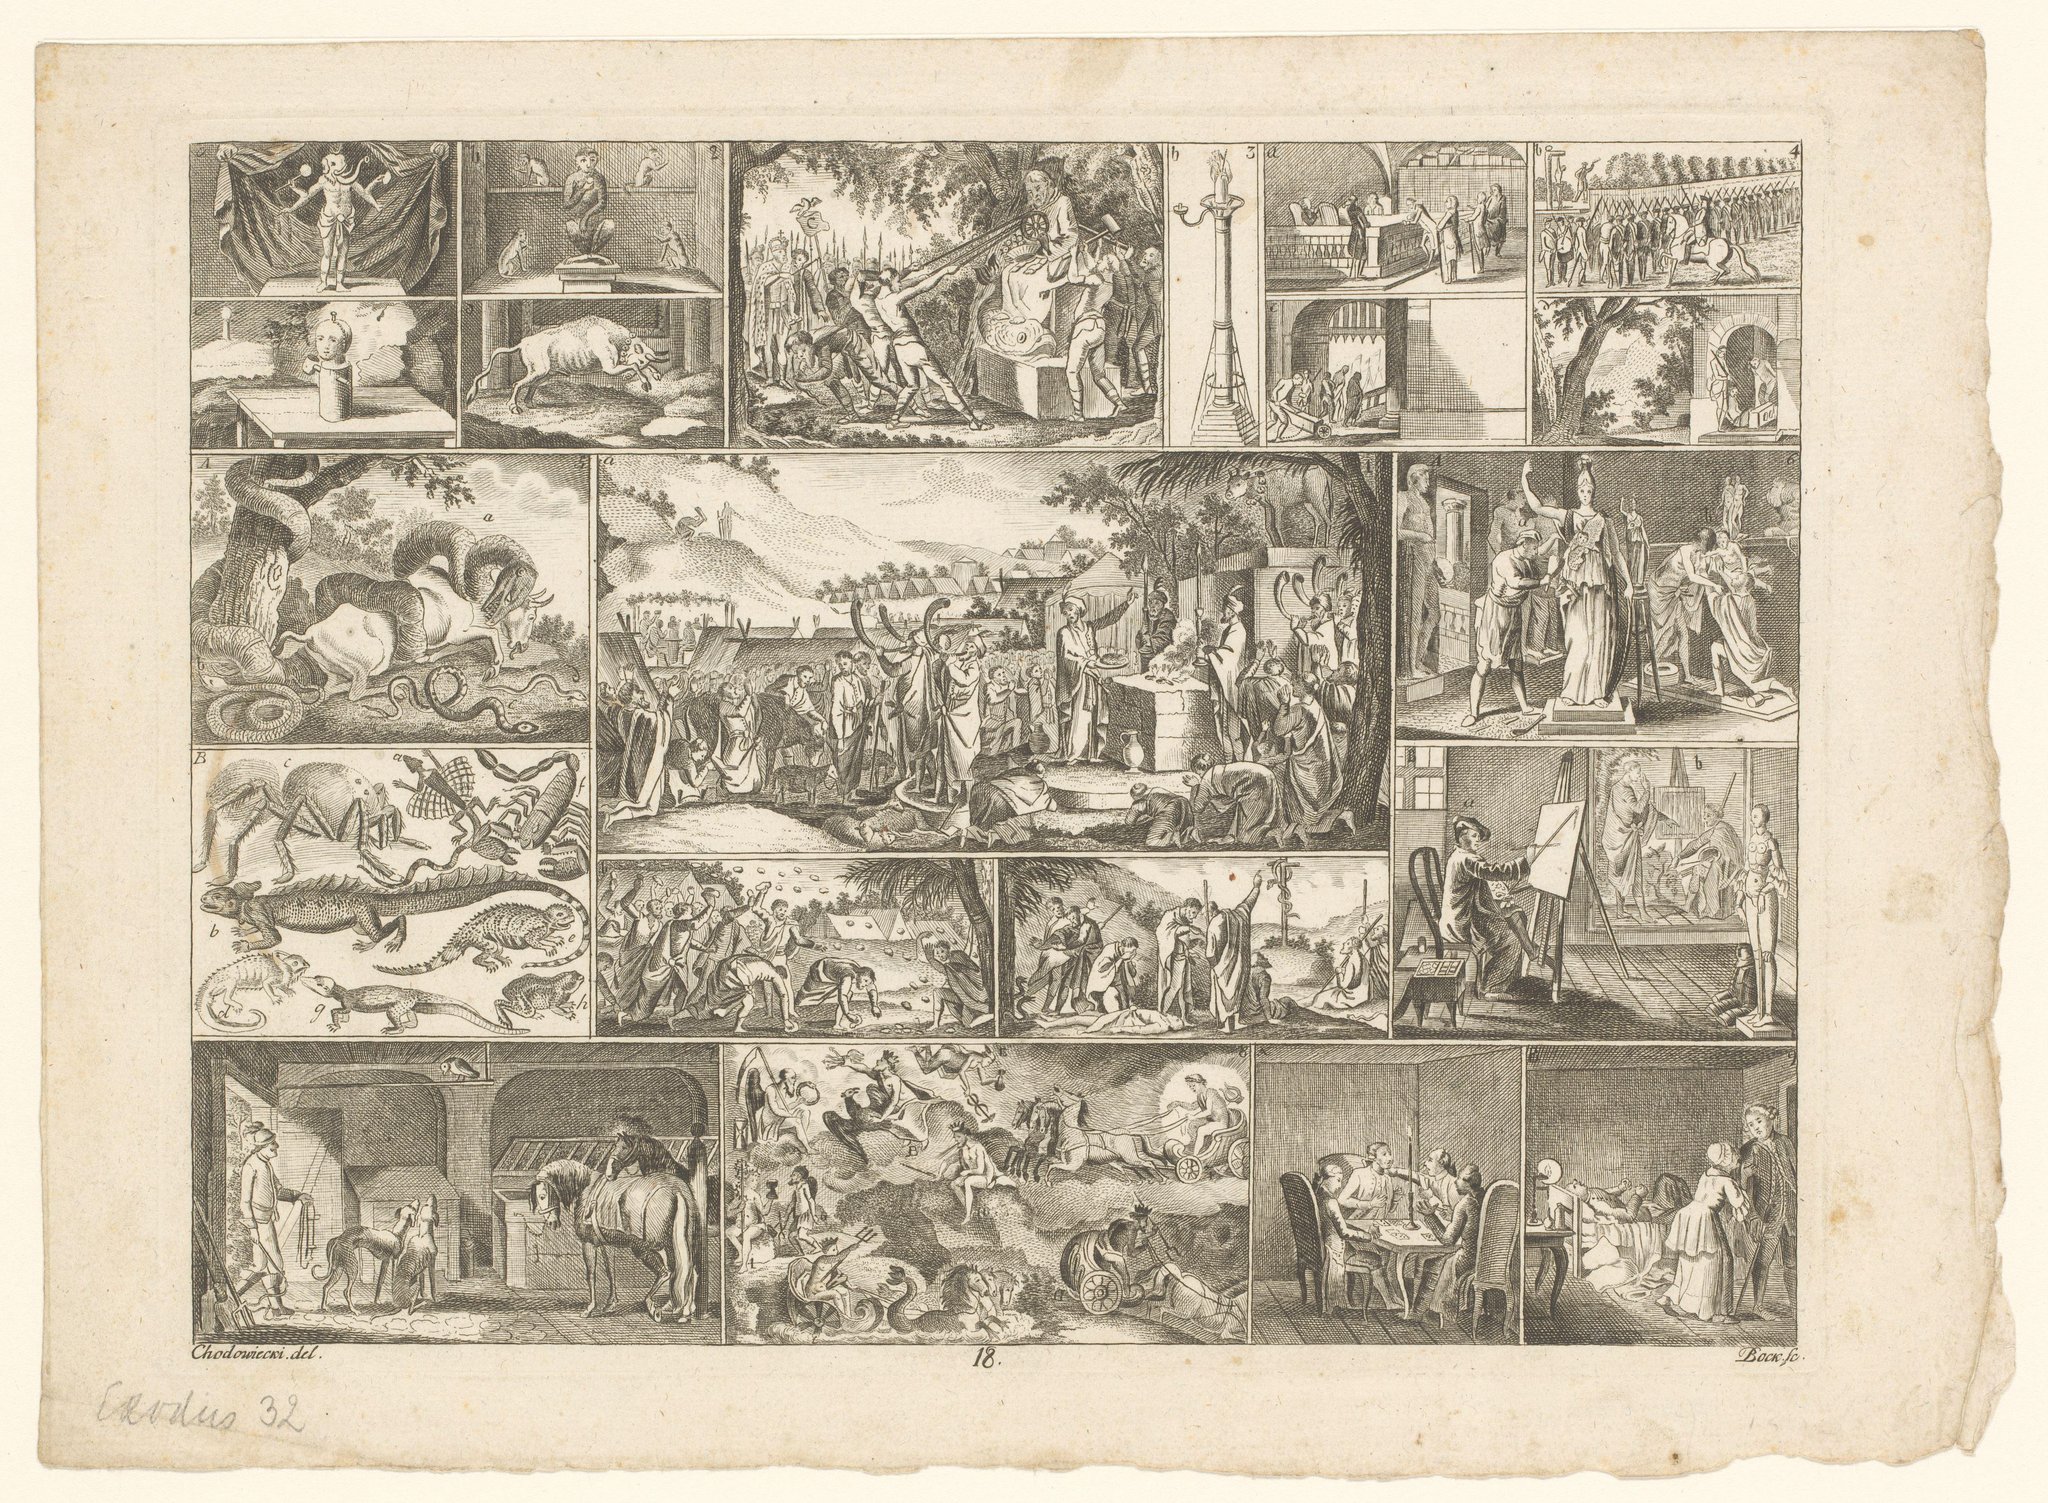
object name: print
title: Blad met uiteenlopende encyclopedische voorstellingen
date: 1784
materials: paper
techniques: engraving, etching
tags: reptiles, the adoration of the golden calf ~ aaron (exodus 32:1-19), painter at work, in his studio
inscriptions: collector's mark: Lugt 2228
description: Maakt deel uit van een serie encyclopedische prenten door verschillende kunstenaars naar ontwerp van Daniel Nikolaus Chodowiecki bij Johann Sigmund Stoy's 'Bilder-Akademie für die Jugend', uitgegeven te Neurenberg in 1784. De prenten waren bedoeld voor kinderen om uit te knippen, op kaarten te plakken en vervolgens op logische wijze te rangschikken (zie Heesen, Anke te. The World in a Box: The Story of an Eighteenth-Century Picture Encyclopedia. Chicago: University of Chicago Press, 2002).